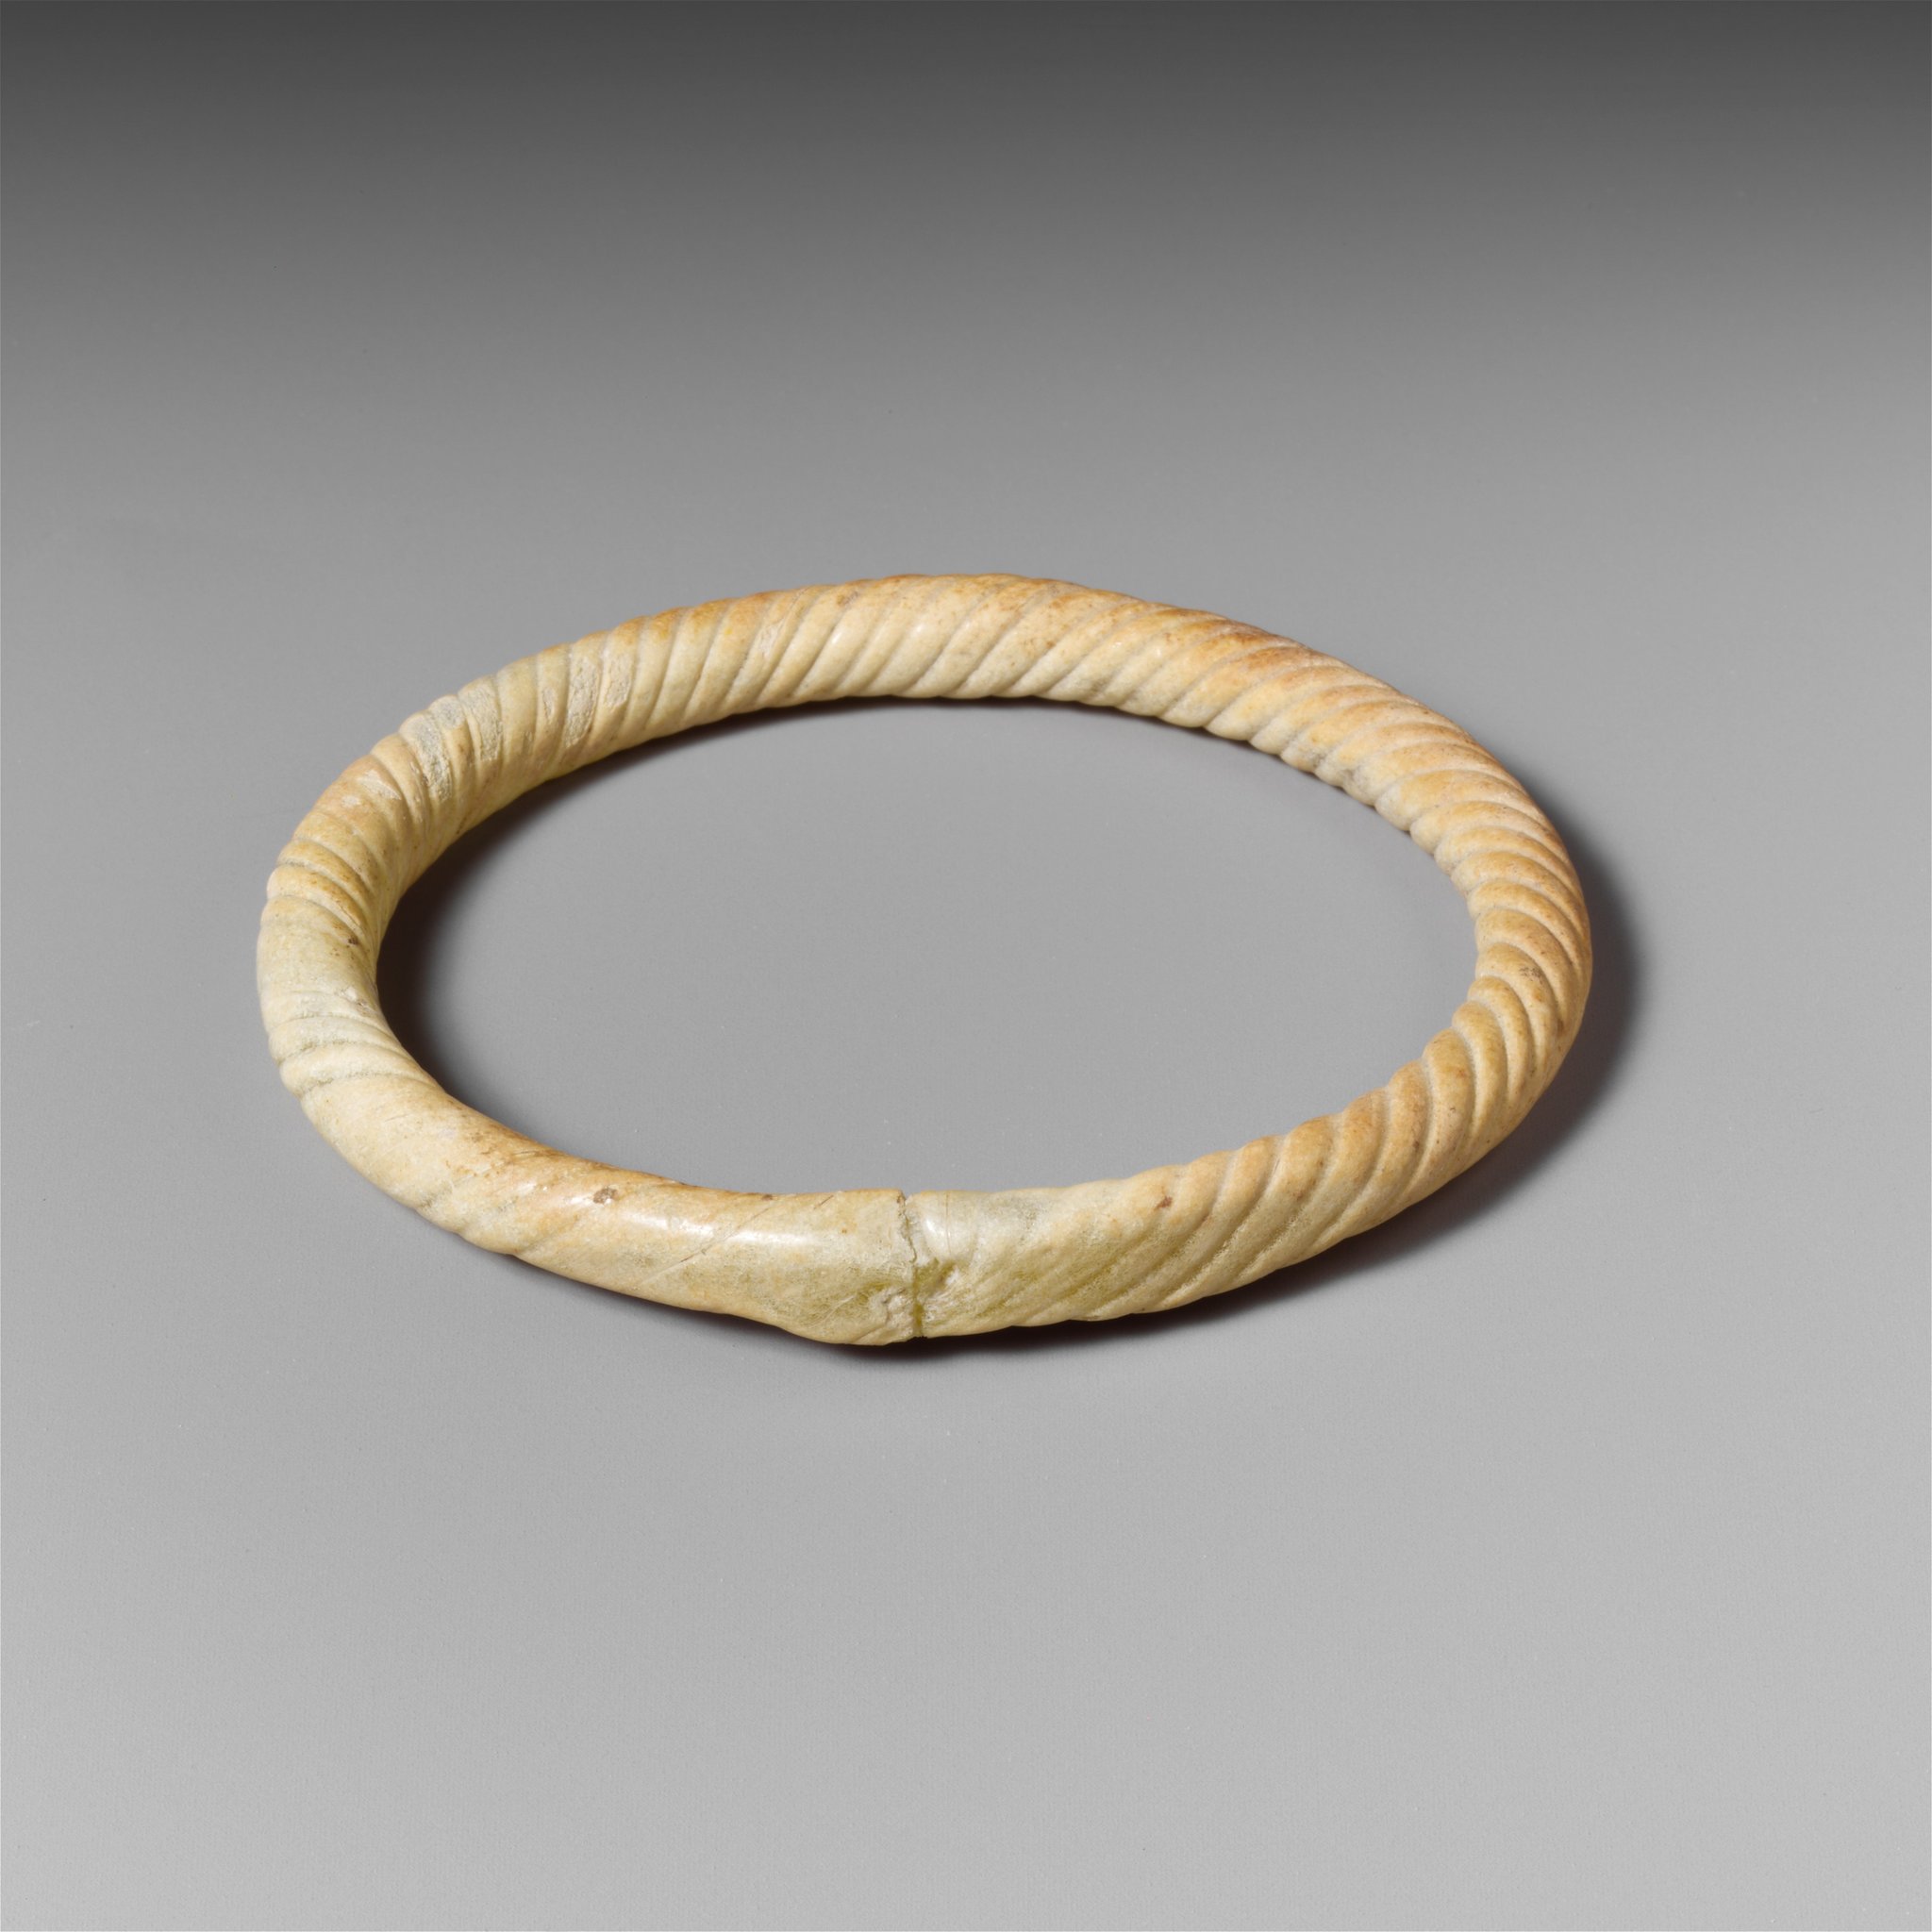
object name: bracelet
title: Glass bracelet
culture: roman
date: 301-400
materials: glass